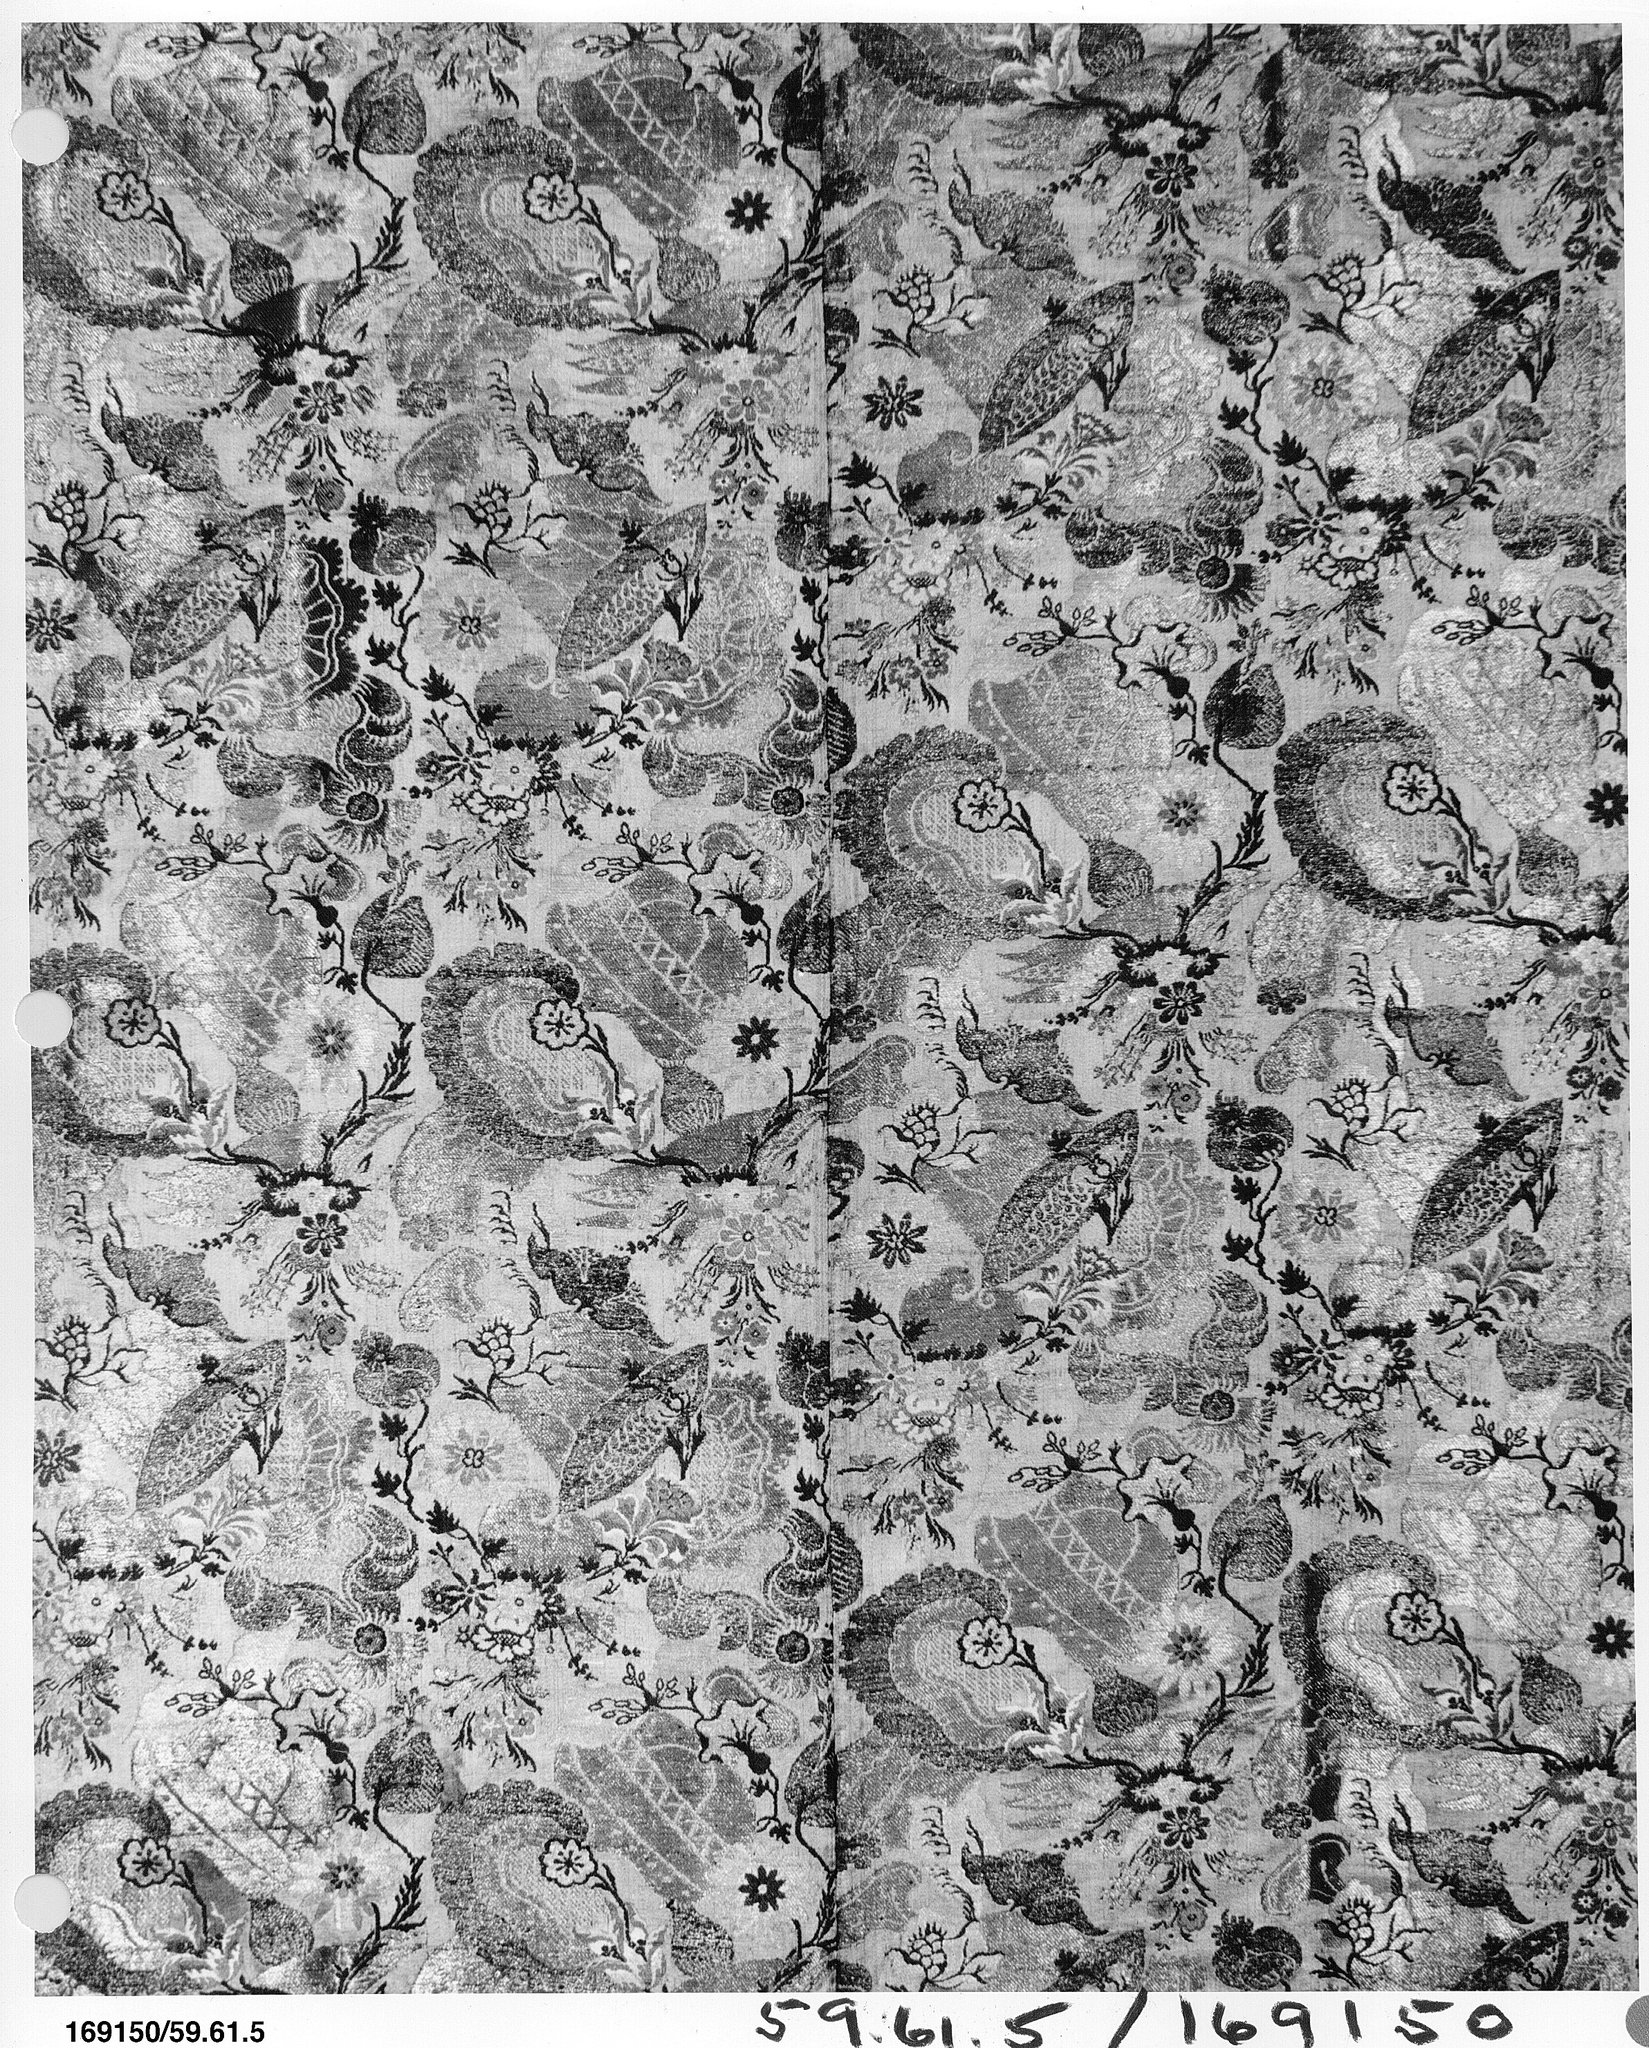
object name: piece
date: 1701-1733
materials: metal thread, silk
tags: flowers,leaves